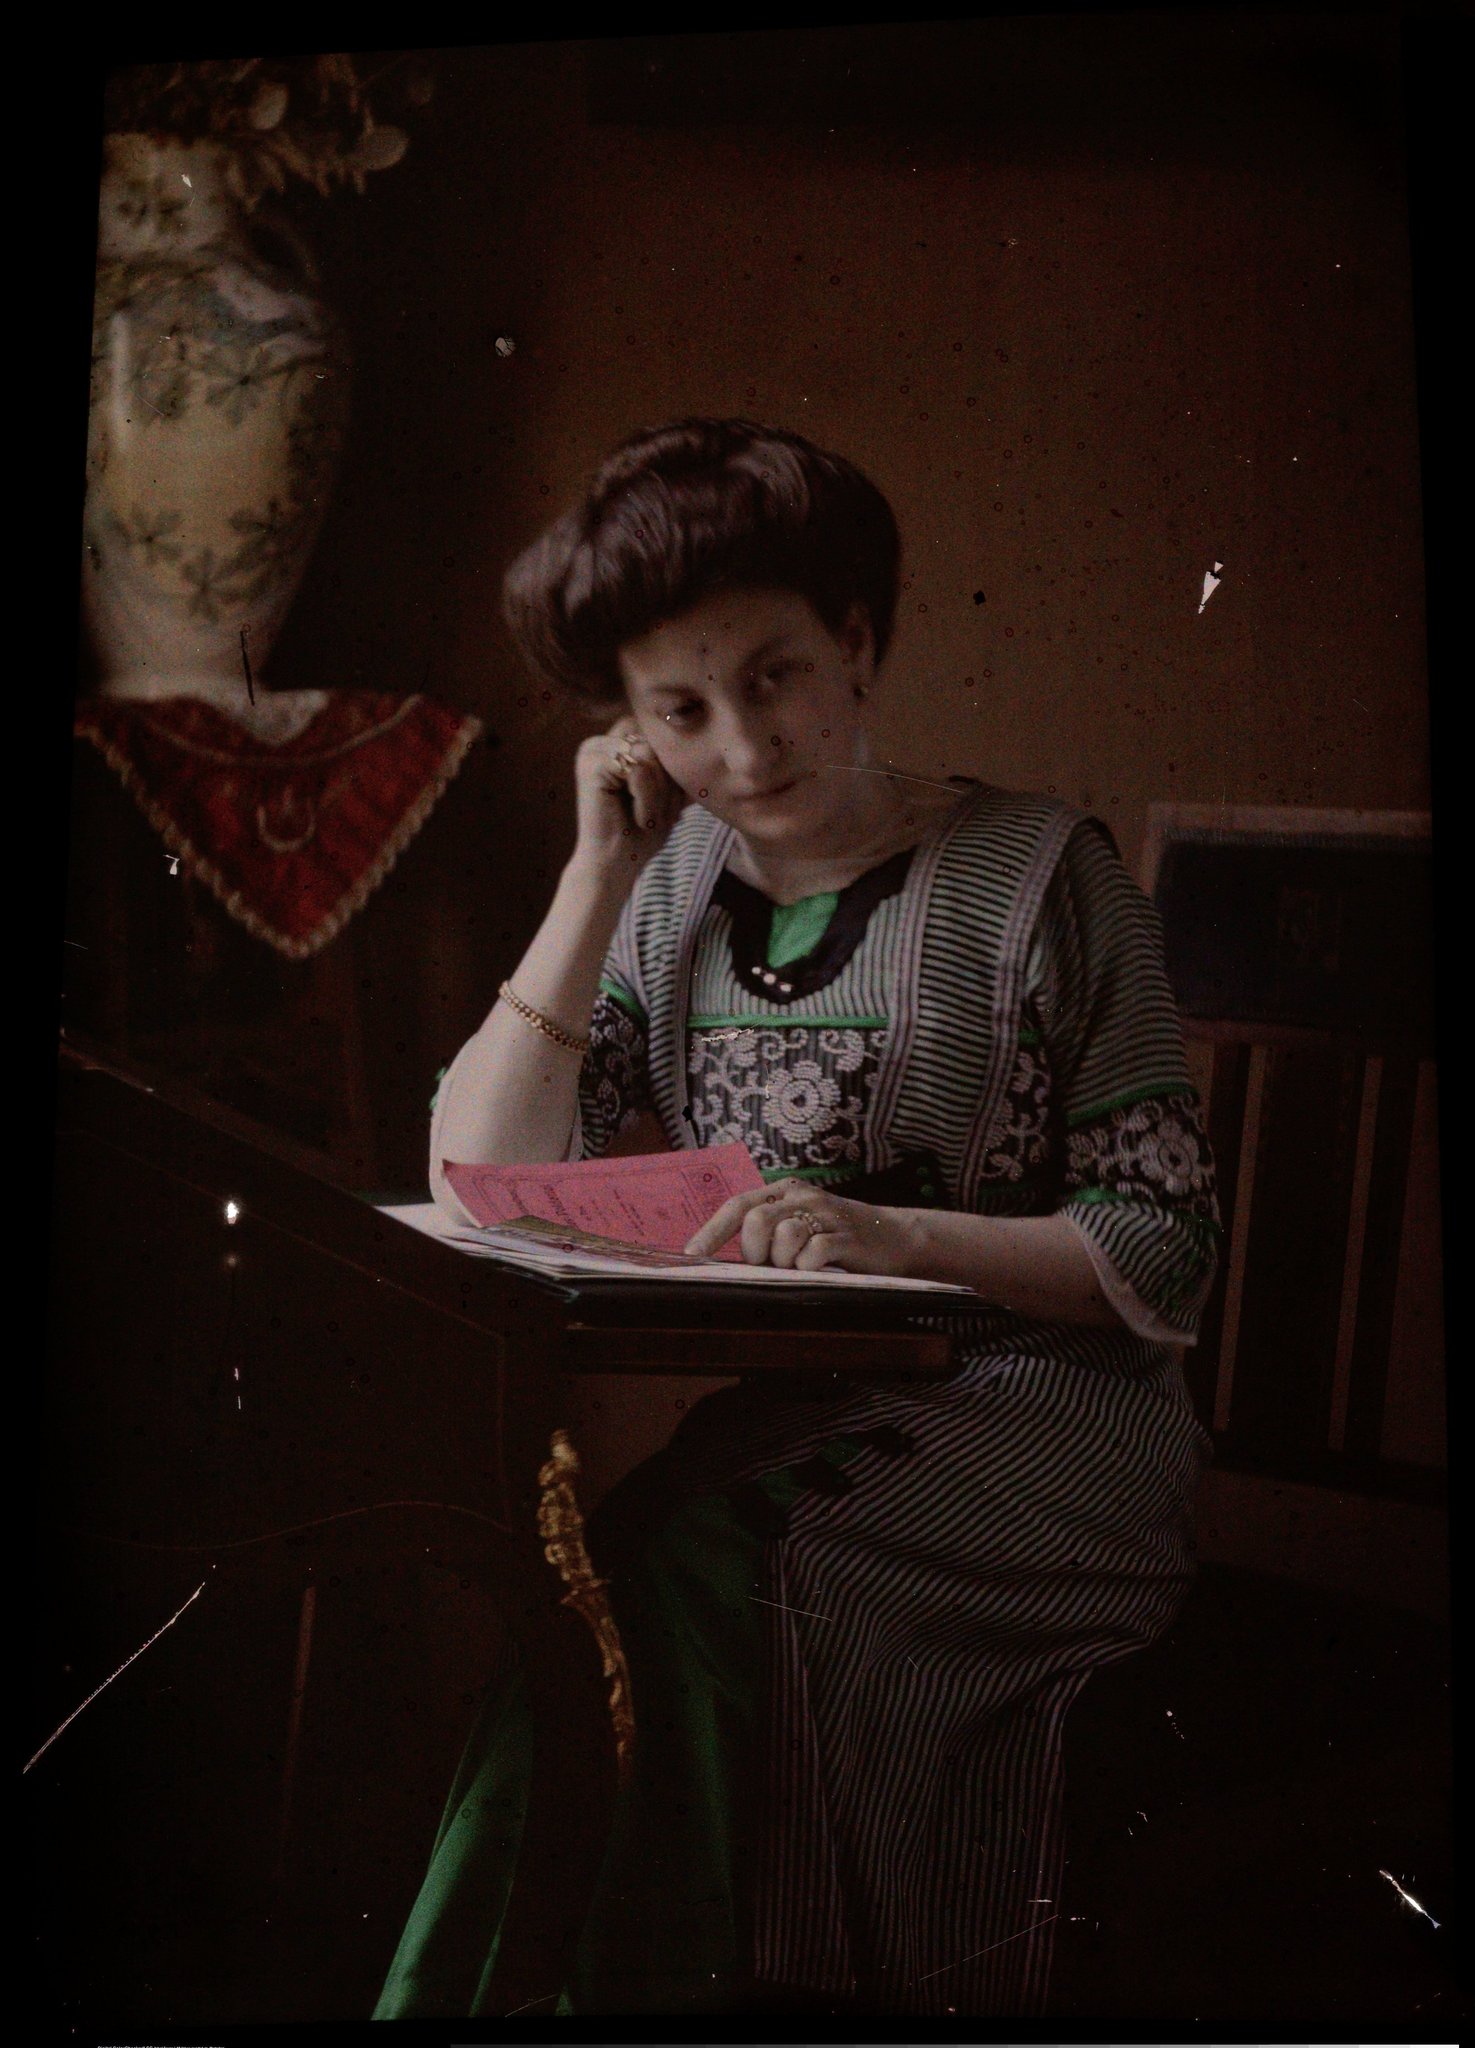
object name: photograph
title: Vrouw achter leestafel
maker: johannes hendrikus antonius maria lutz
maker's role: fotograaf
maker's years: -1916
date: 1907-1916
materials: glass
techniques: autochrome process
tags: reading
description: Jonge vrouw zittend achter een leestafel.